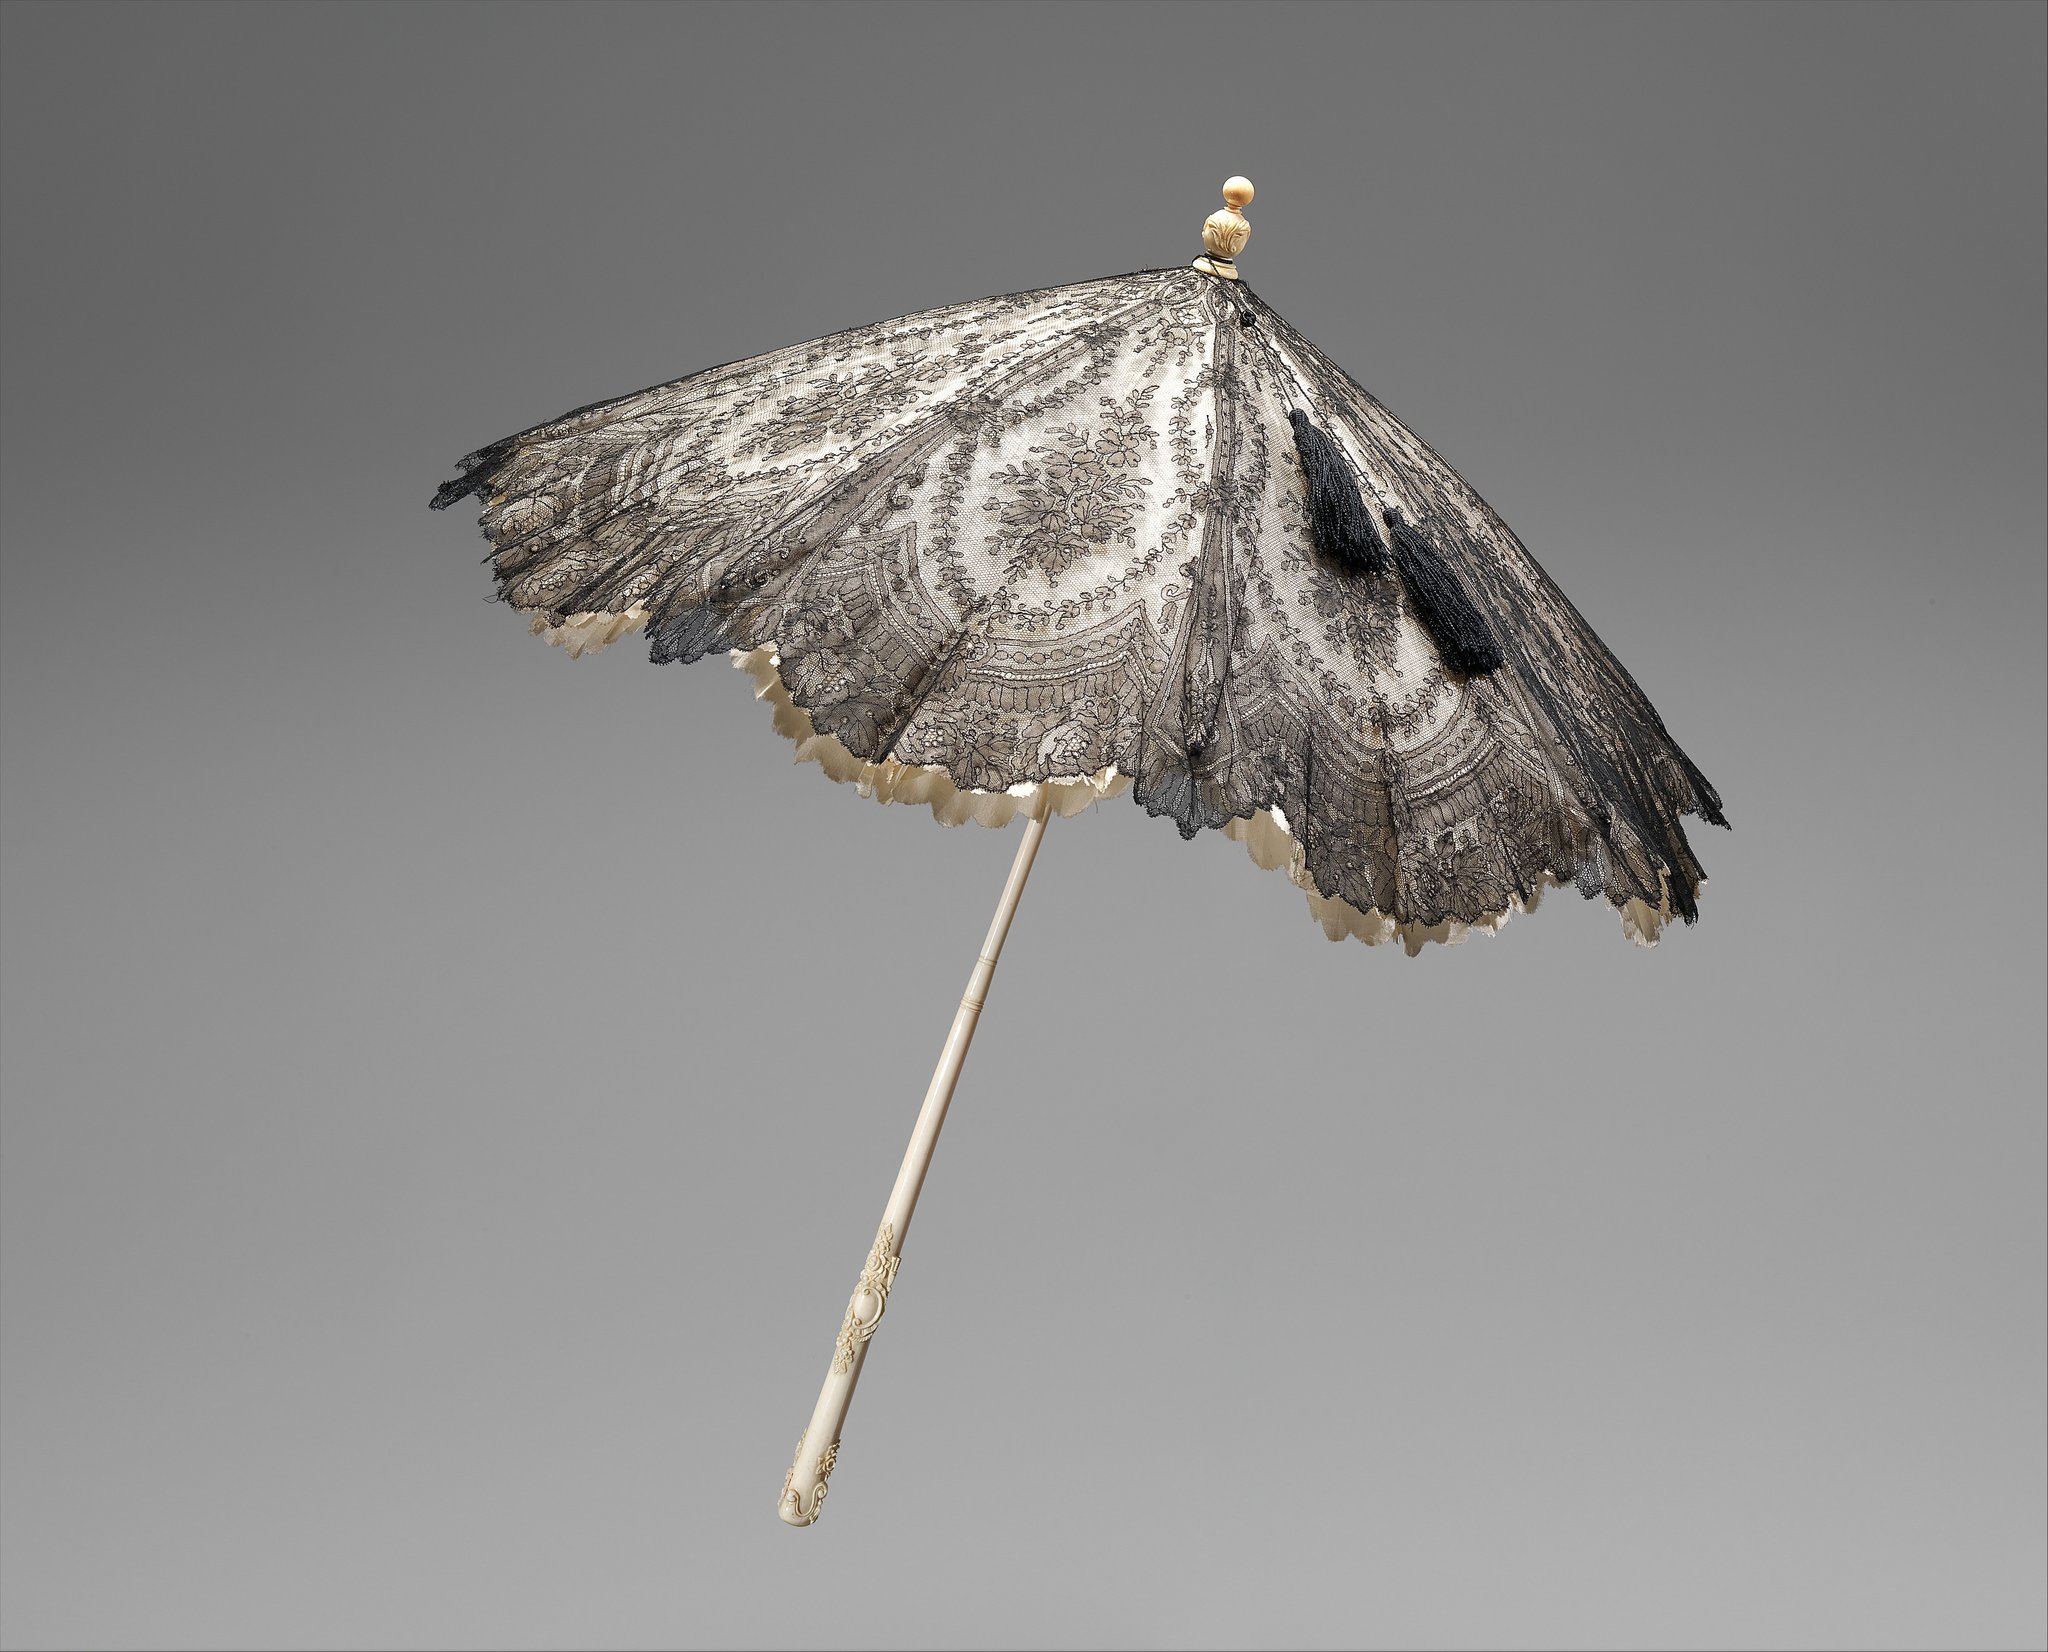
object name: parasol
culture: french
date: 1860-1869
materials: silk